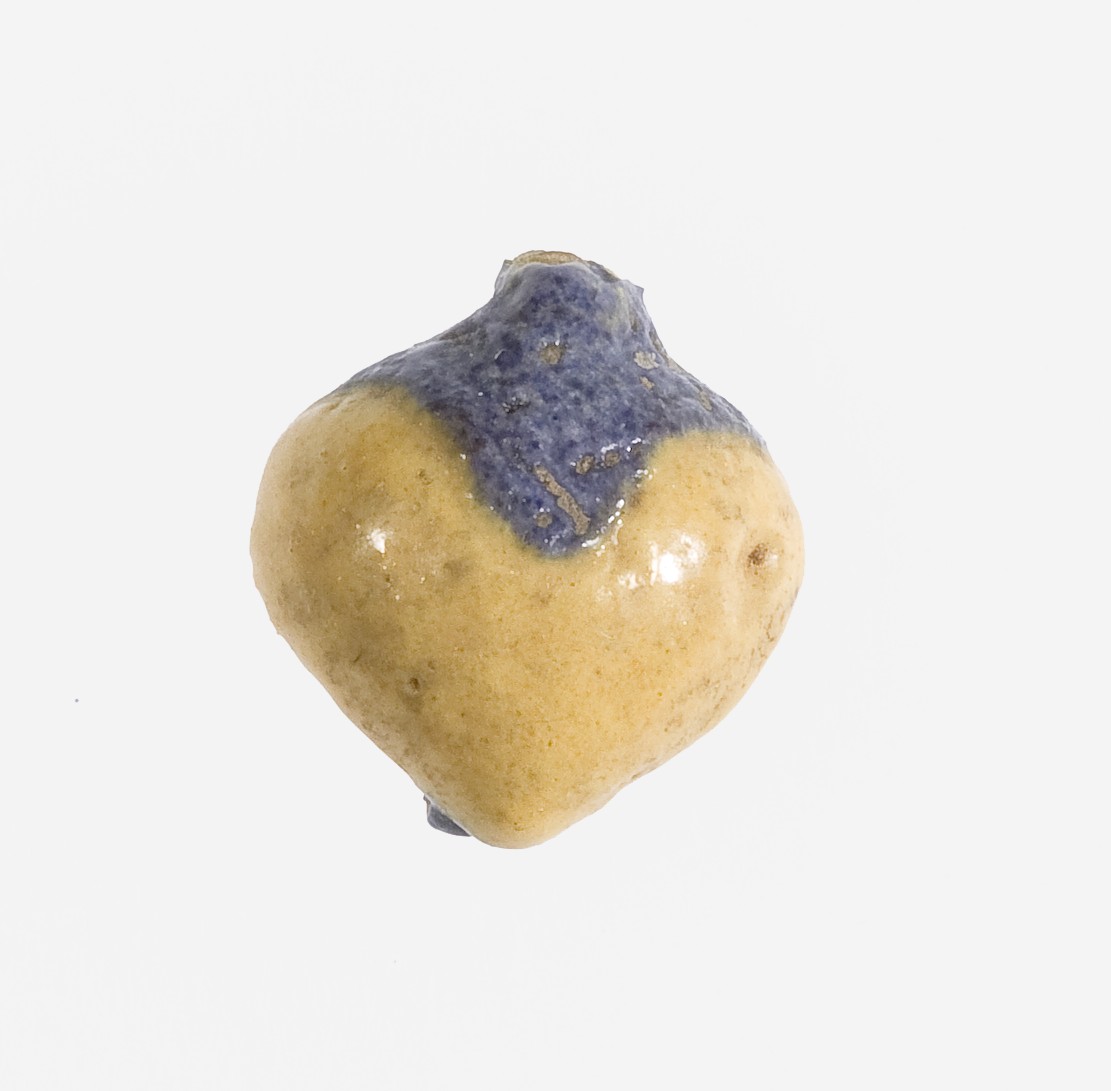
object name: pendant, persea fruit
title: Persea fruit pendant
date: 1390-1352 BCE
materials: faience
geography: egypt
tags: fruit